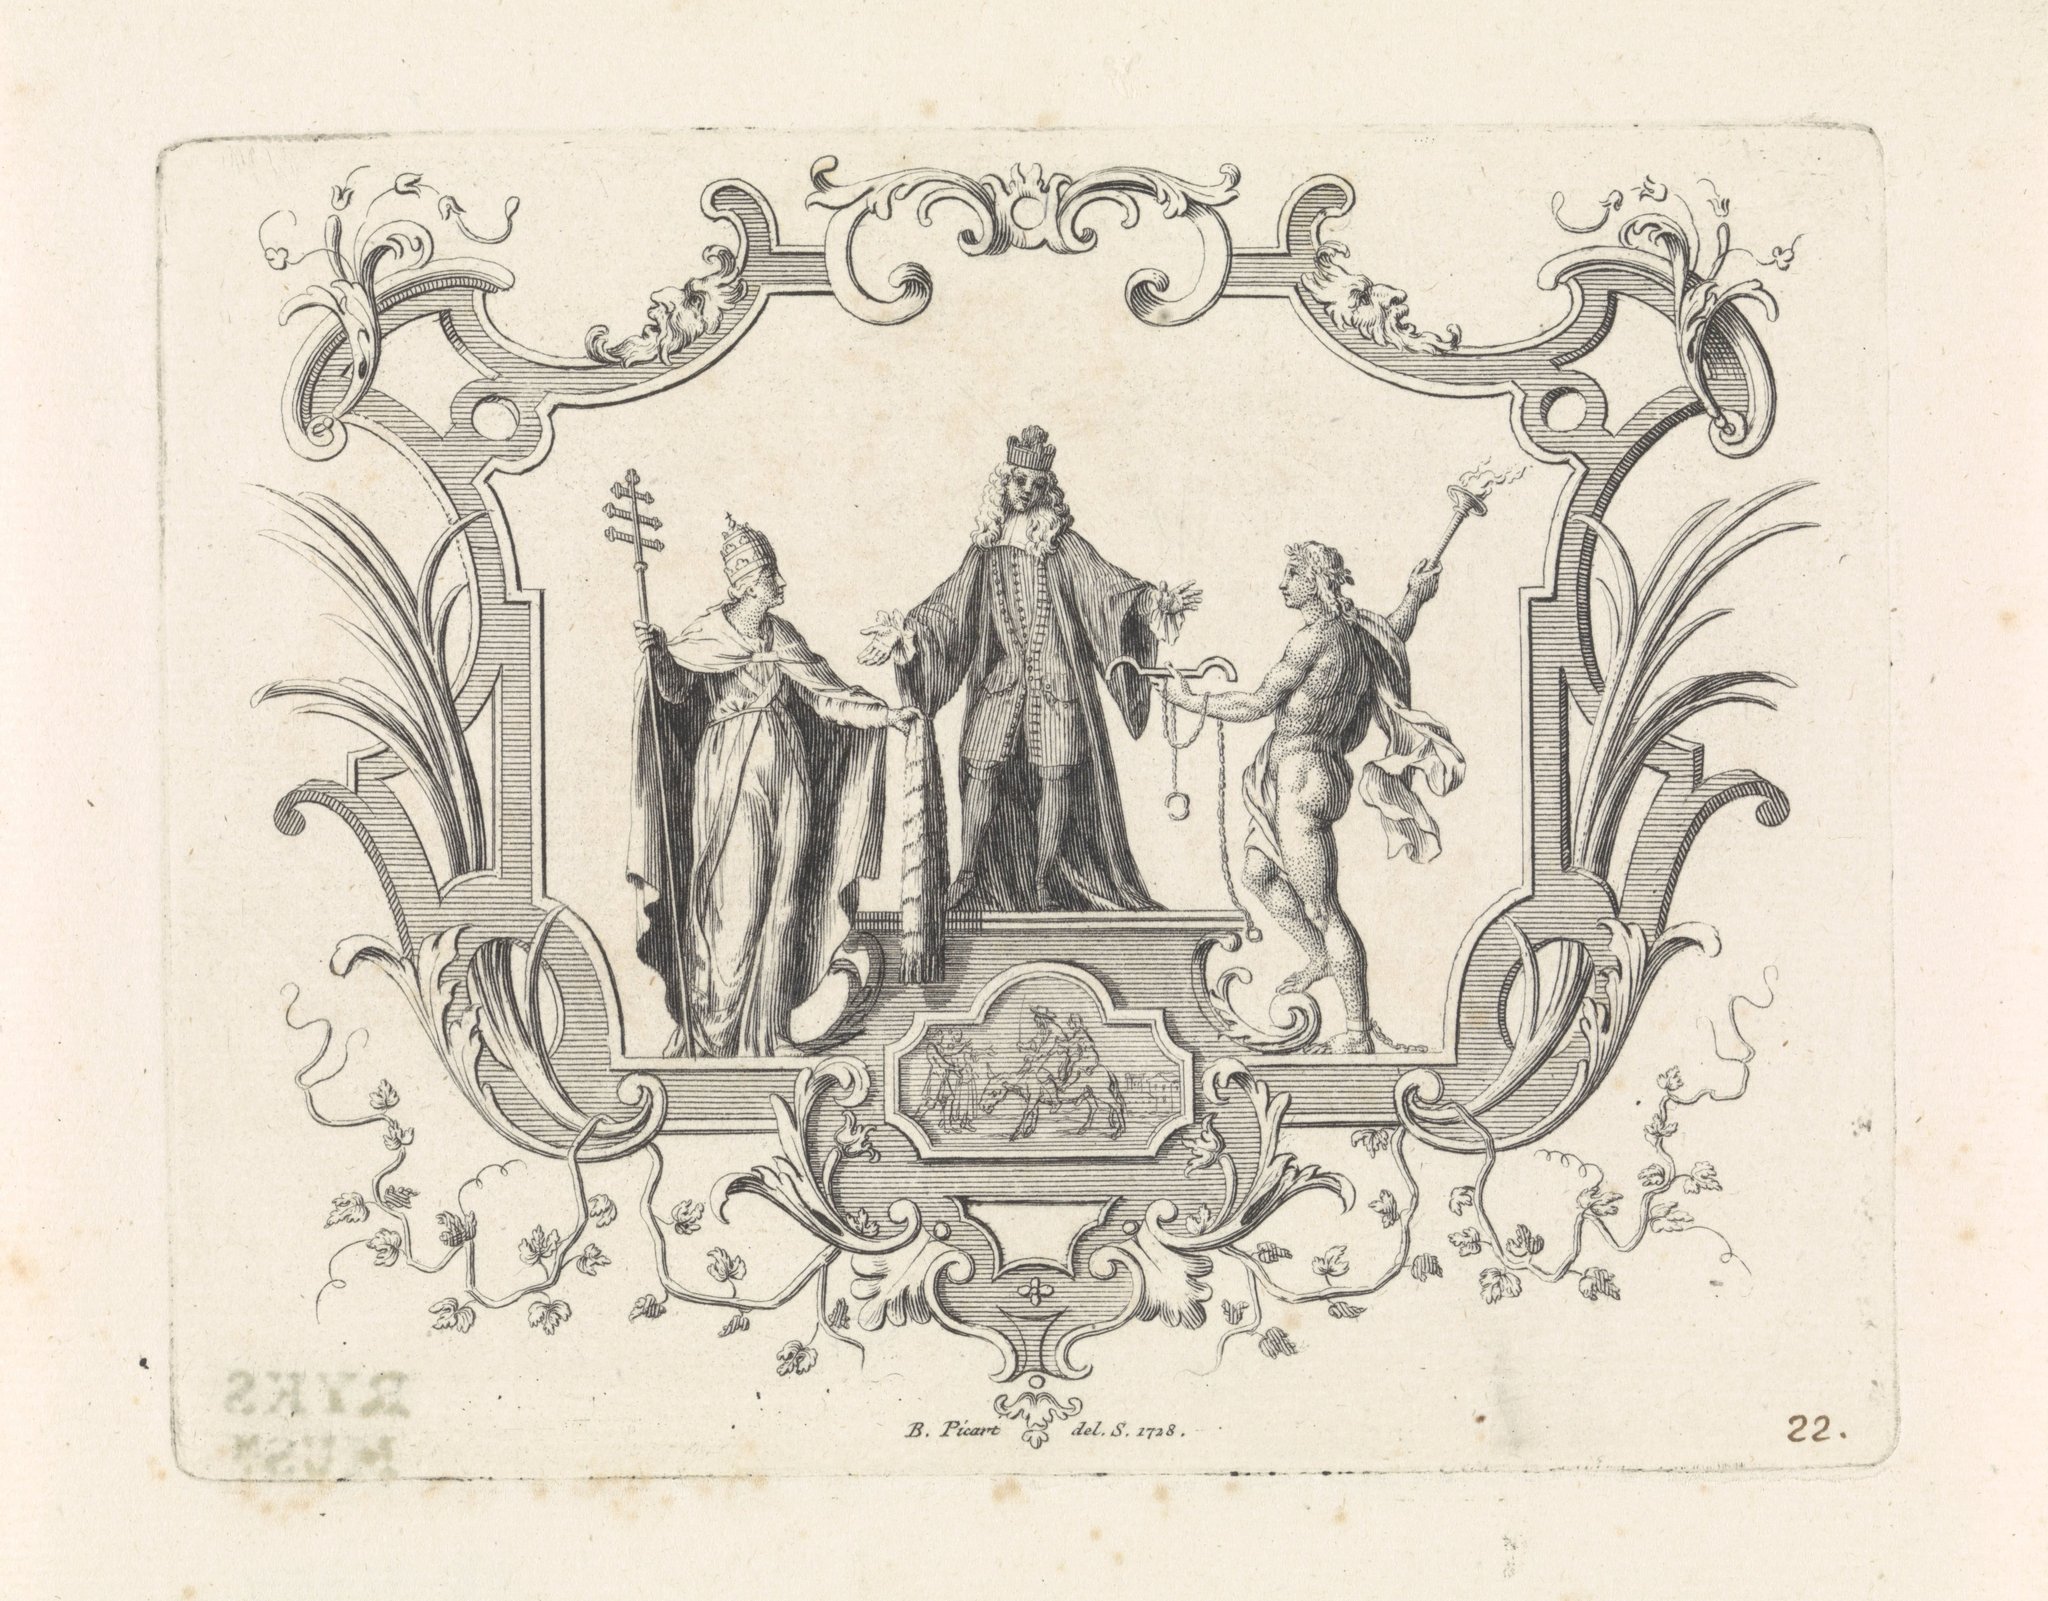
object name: ornament print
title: François de Maucroix geflankeerd door de Kerk en Hymen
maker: bernard picart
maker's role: draughtsman, print maker, publisher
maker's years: 1673-1733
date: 1728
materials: paper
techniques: engraving, etching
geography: amsterdam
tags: ornaments ~ art, (story of) hymen(aeus) (+ attributes), the church personified, 'ecclesia', usually with chalice and banner (+ variant), pope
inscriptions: number: ‘22.’, collector's mark: Lugt 2165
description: Prent mogelijk gebruikt in: Boileau-Despréaux, Nicolas. Oeuvres. Amsterdam: François Changuion, Den Haag, Pieter de Hondt, 1729. Nummer 22 in: Explication des Vignettes de la Seconde Edition des Oeuvres de Boileau. Amsterdam: Bernard Picart, 1729.